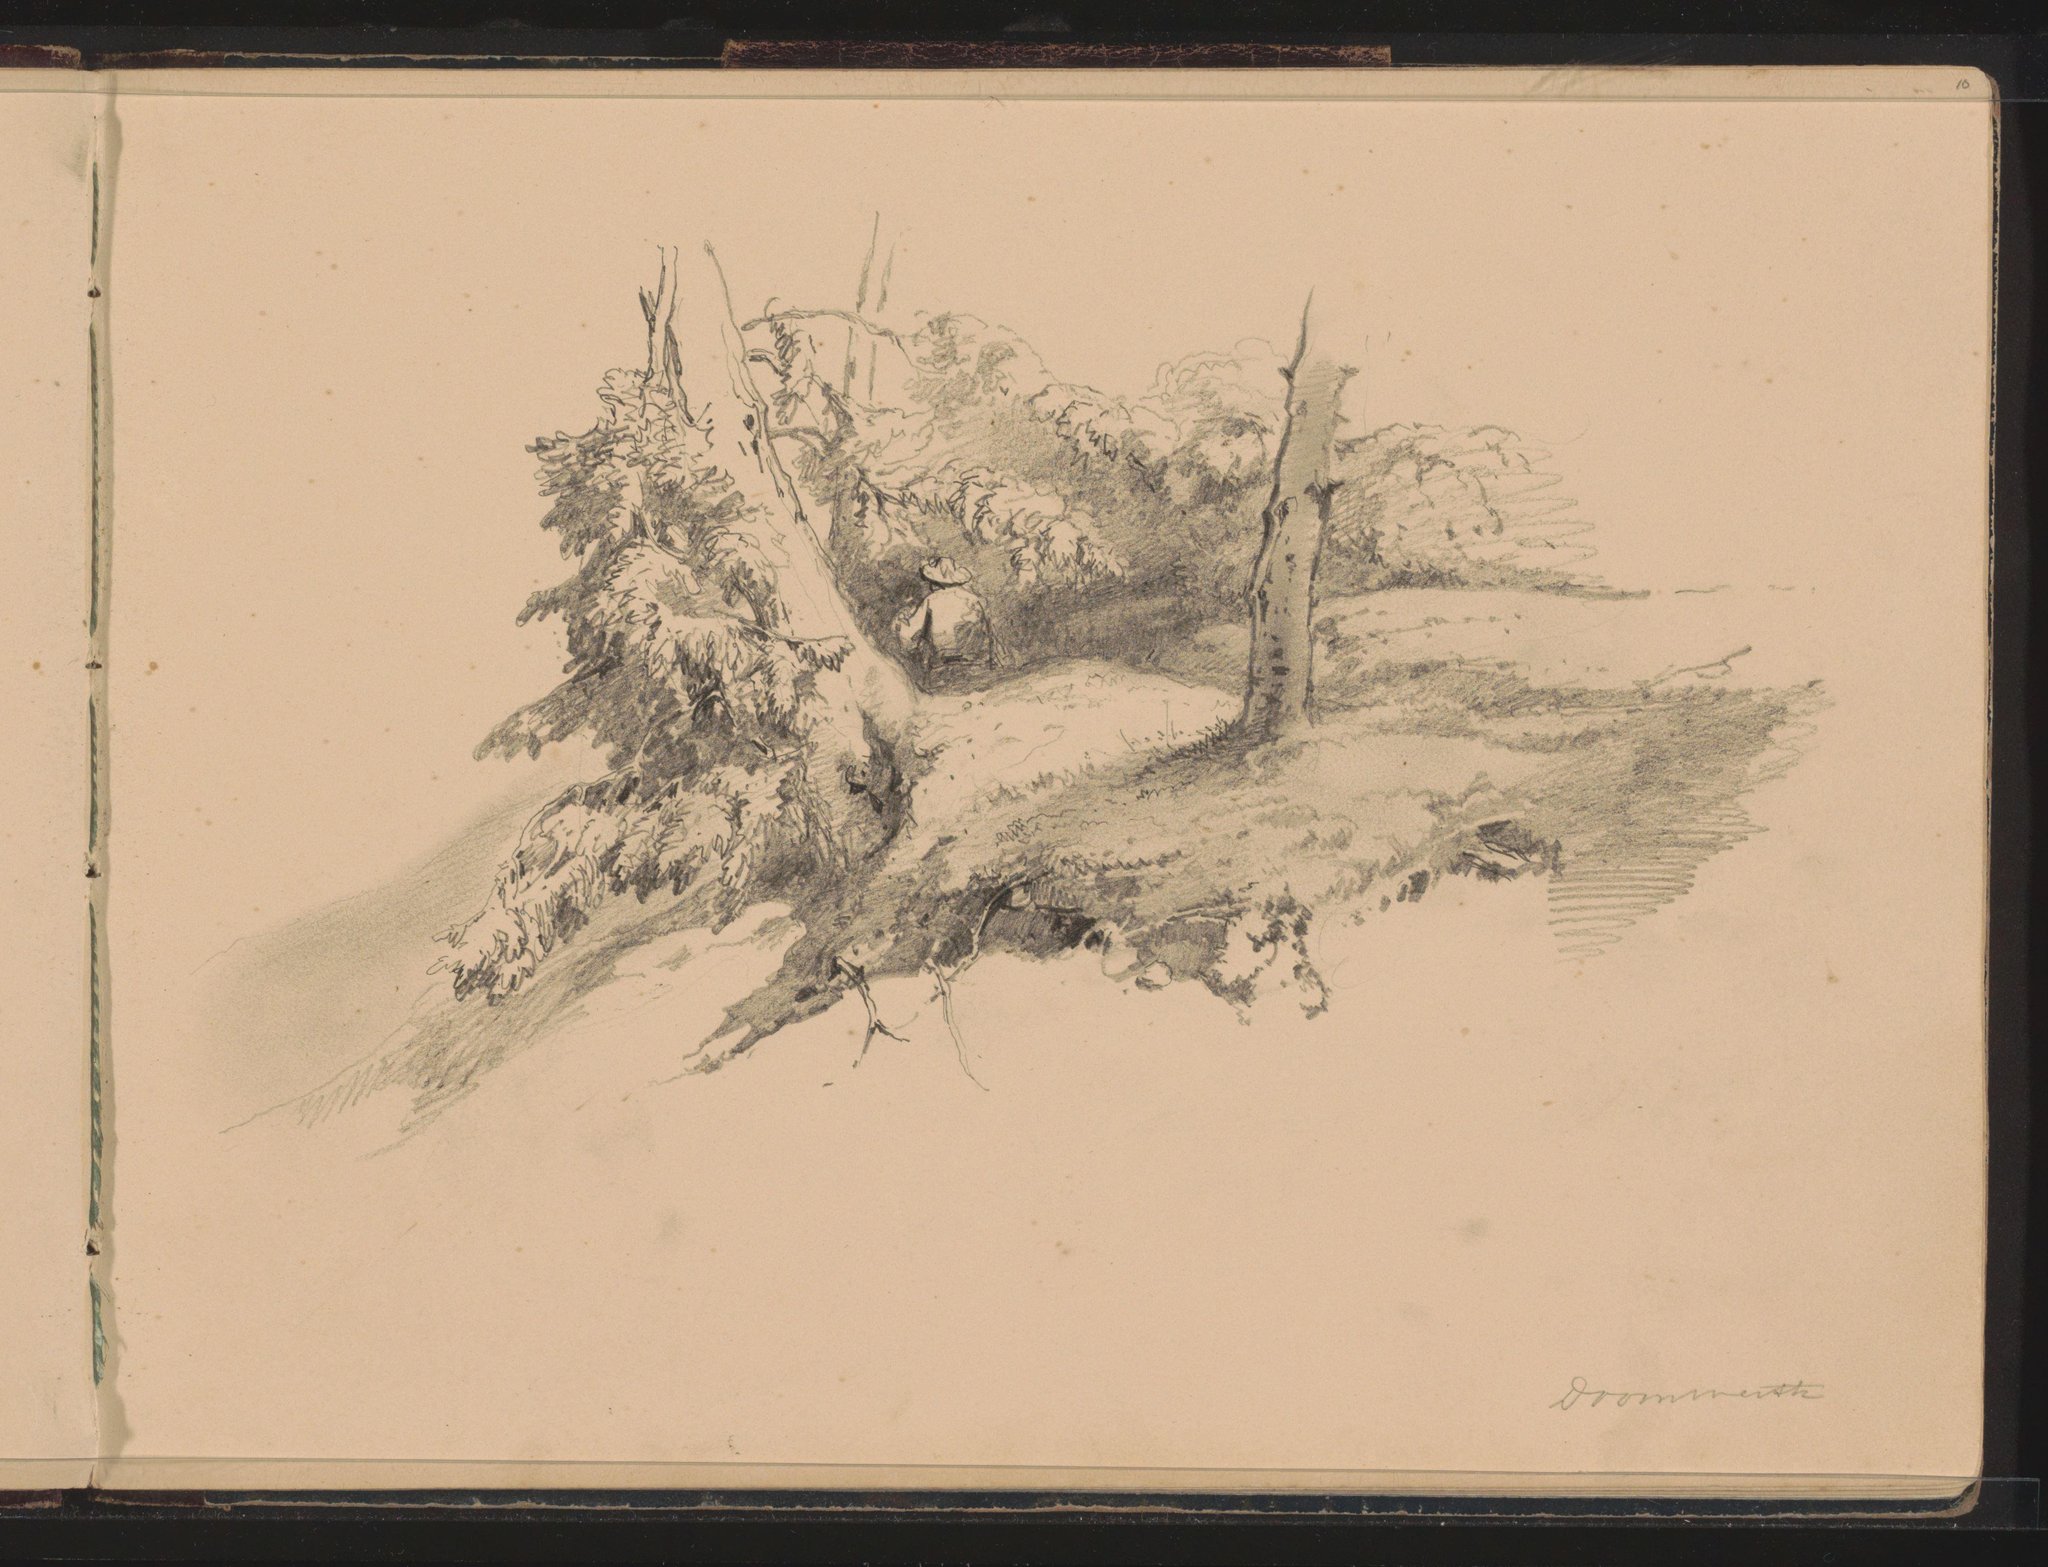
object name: sketchbook leaf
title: Bomen in Doorwerth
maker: maria vos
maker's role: draughtsman, painter, print maker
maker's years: 1824-1906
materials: paper, pencil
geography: doorwerth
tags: trees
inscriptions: annotation: ‘Doornwerth’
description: Blad 10 recto uit een schetsboek met 44 bladen.